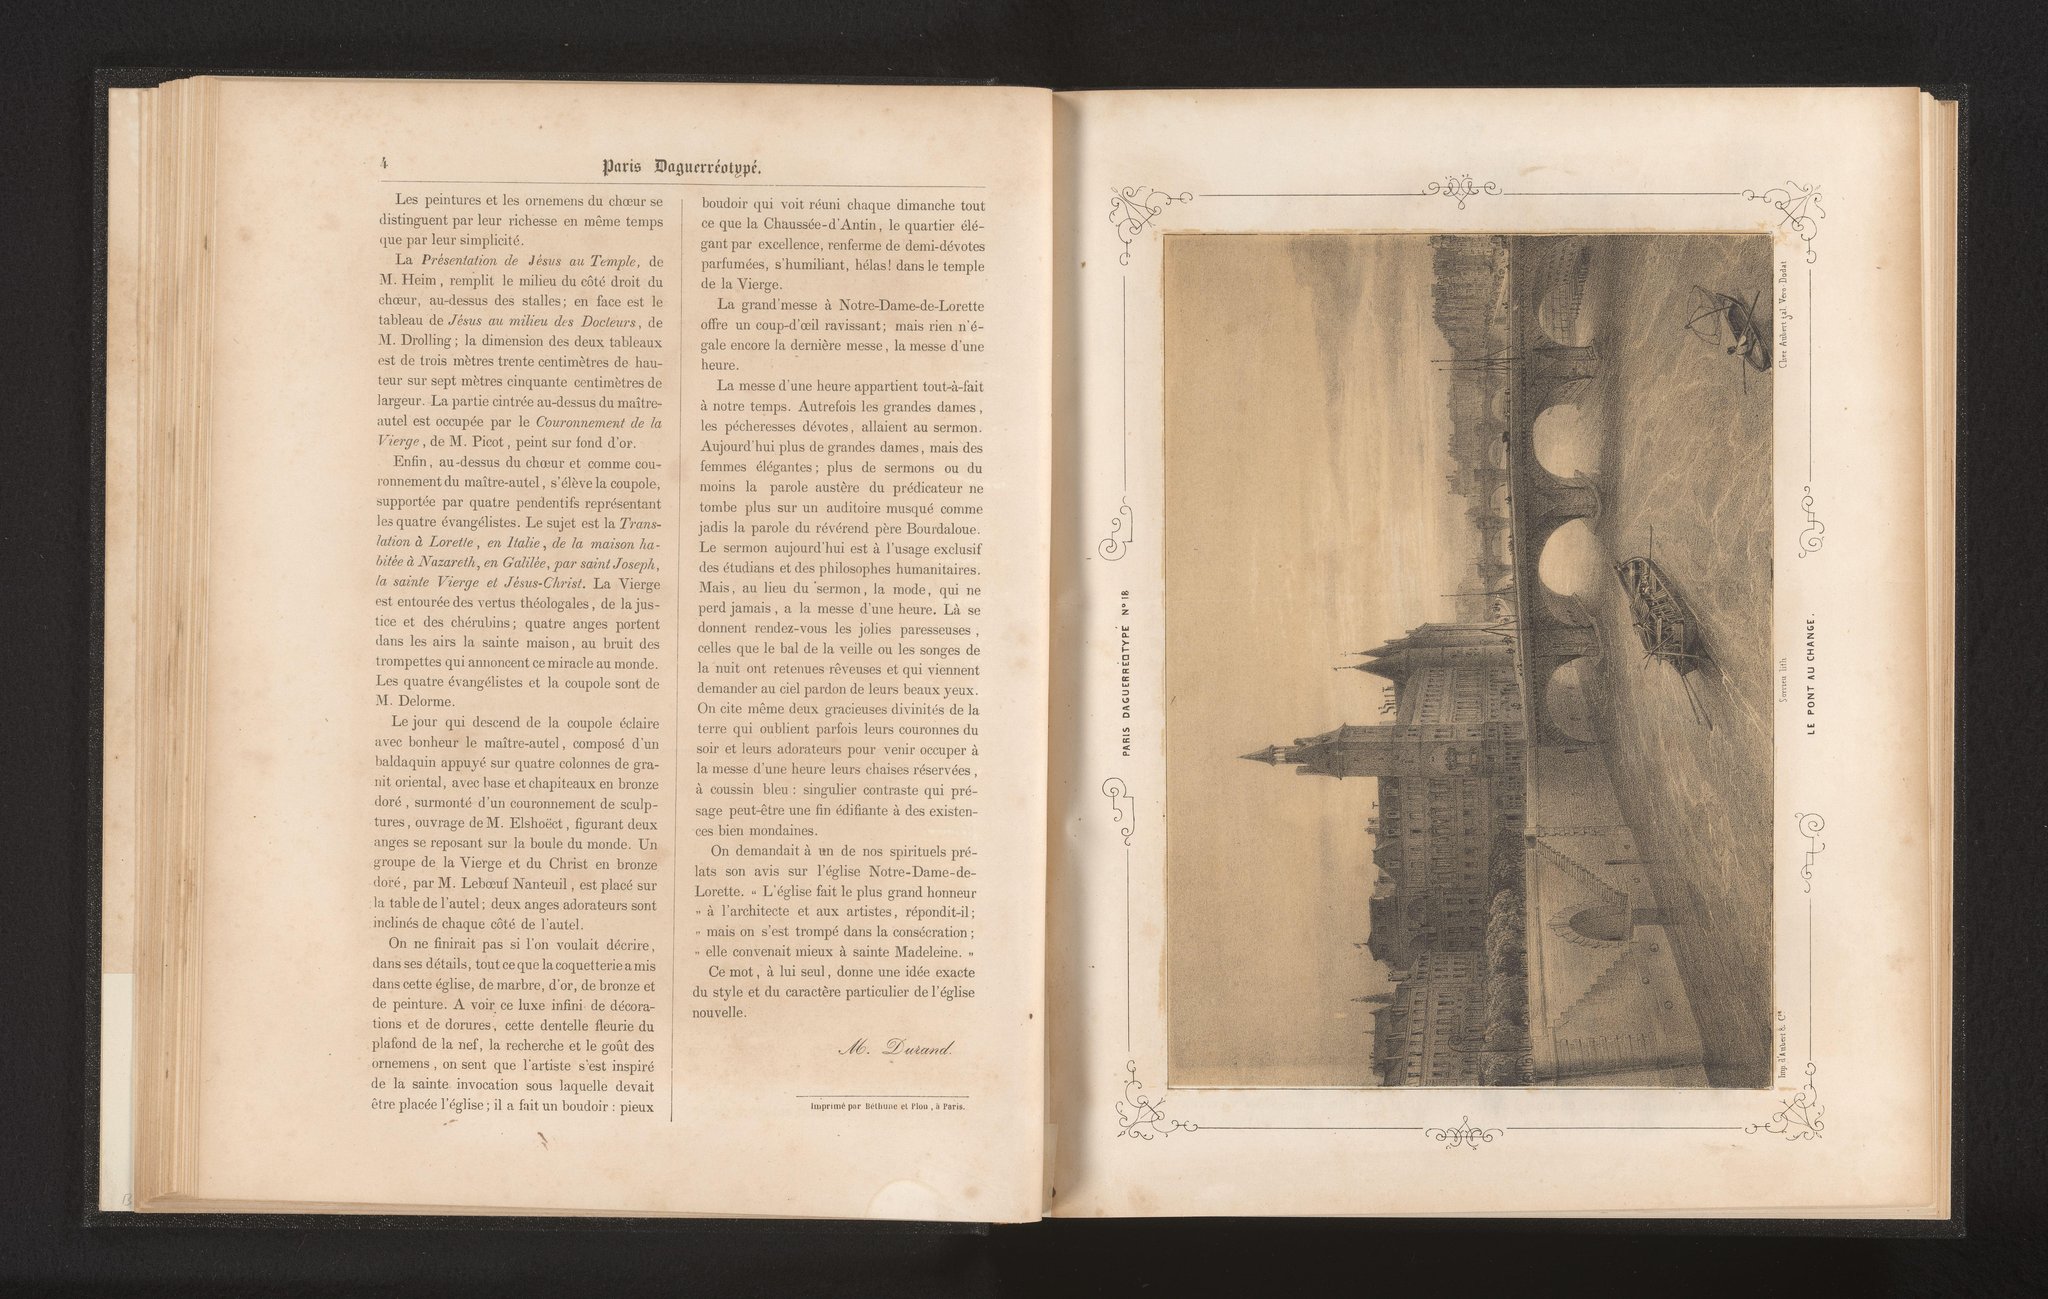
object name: page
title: Pont au Change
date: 1839-1840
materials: paper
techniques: tone lithography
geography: paris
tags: bridge in city across river, canal, etc.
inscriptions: inscription: ‘PARIS DAGUERRÉOTYPÉ No. 18.’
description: Prent op negenenzestigste ongenummerde pagina.